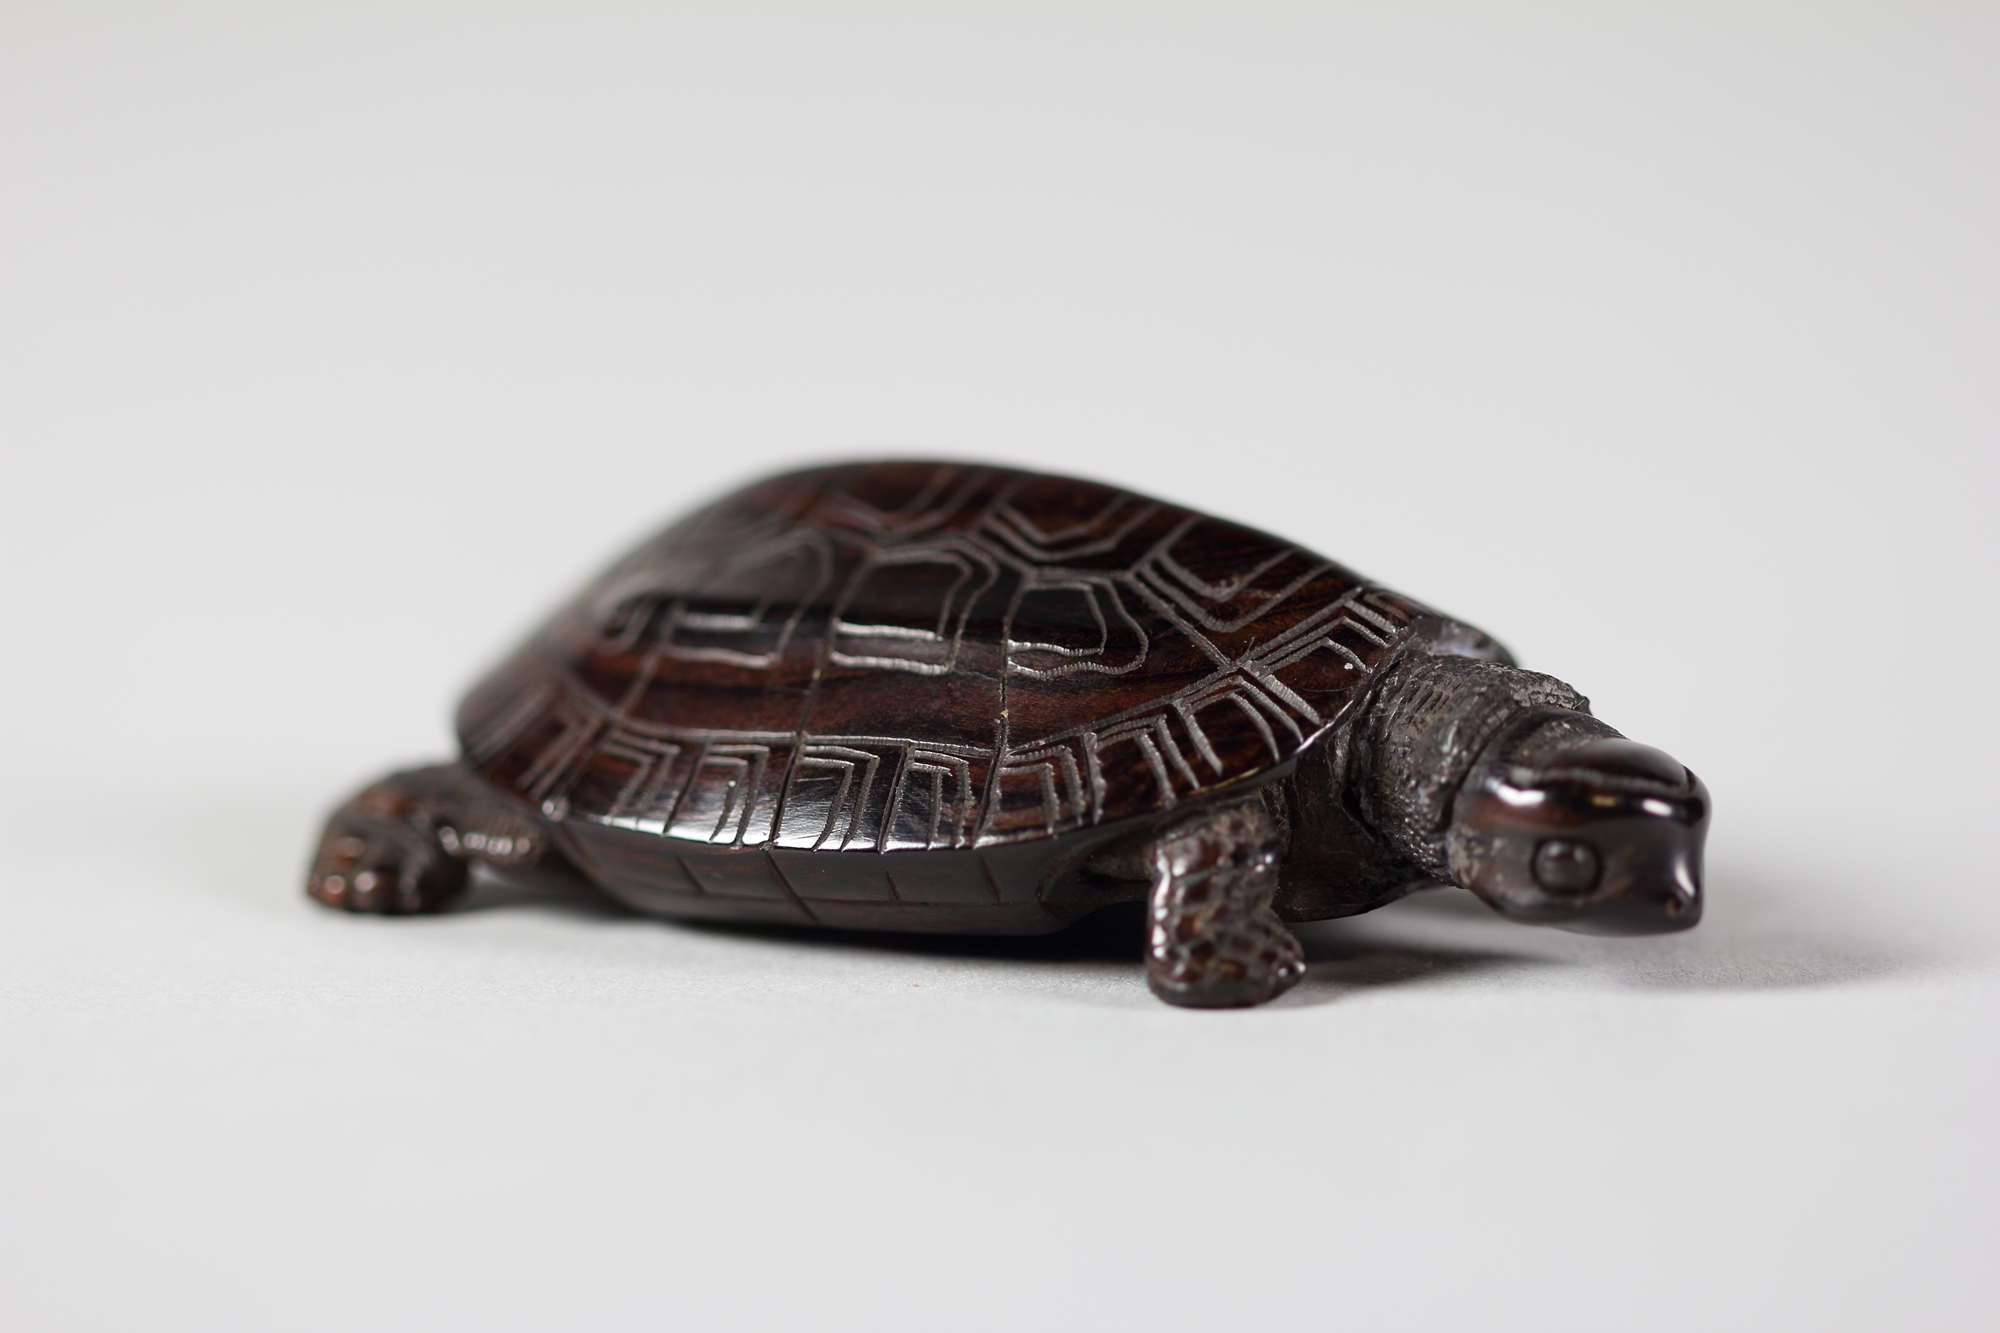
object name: netsuke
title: Netsuke of Turtle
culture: japanese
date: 1801-1900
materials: wood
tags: turtles